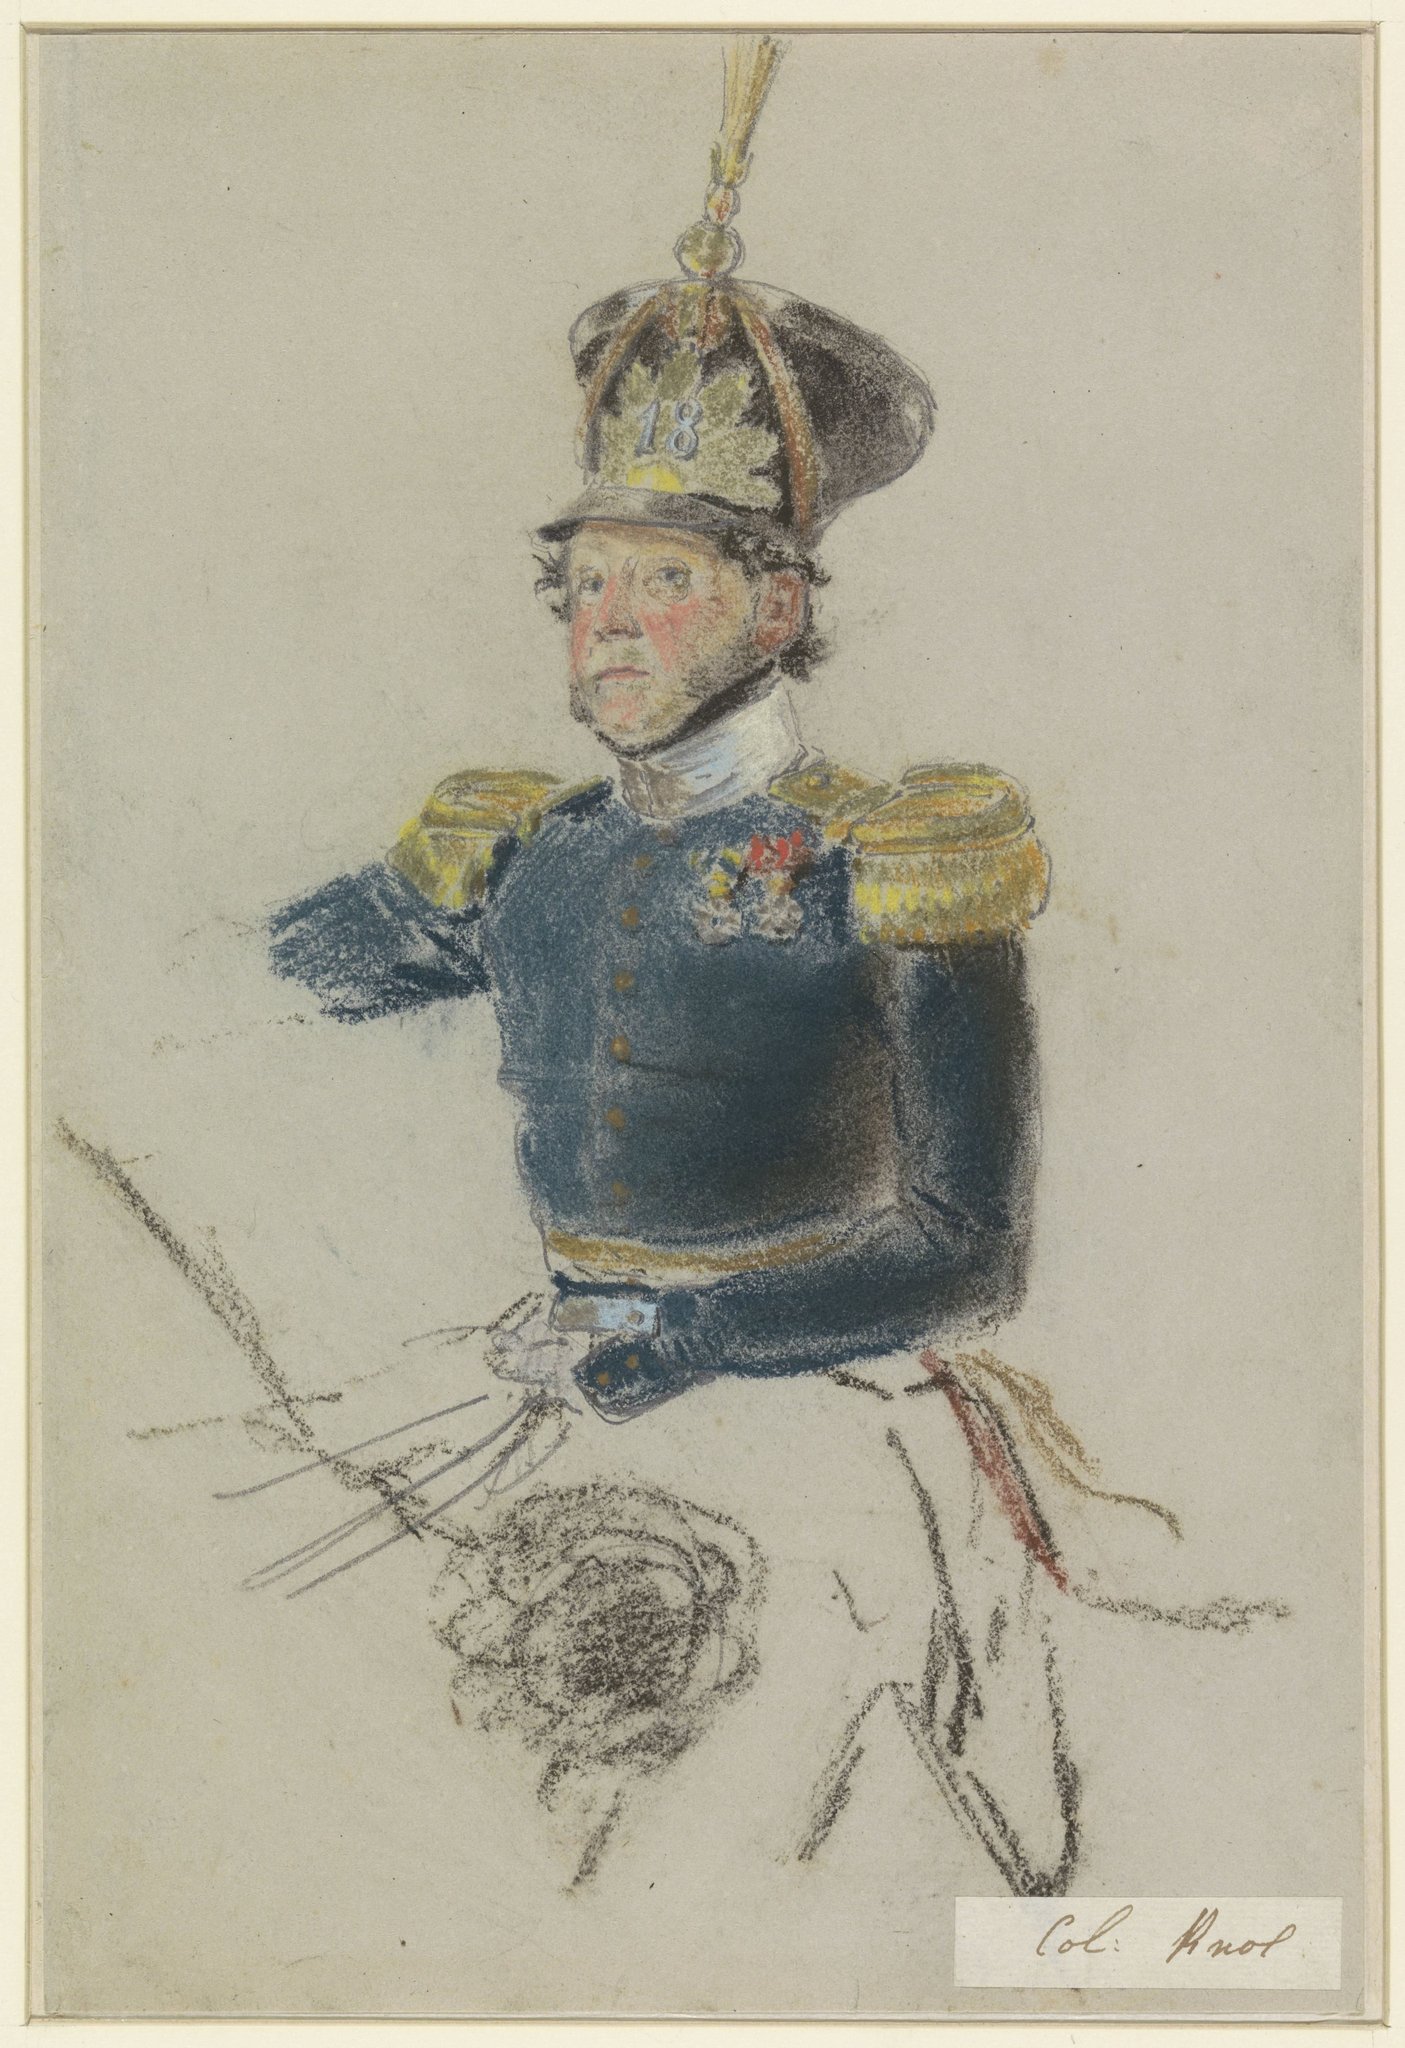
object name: drawing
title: Portret van kolonel Knol, te paard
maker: jacob joseph eeckhout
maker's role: draughtsman, print maker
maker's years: 1793-1861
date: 1803-1861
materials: paper, pastel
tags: historical persons, officer (with name of rank)